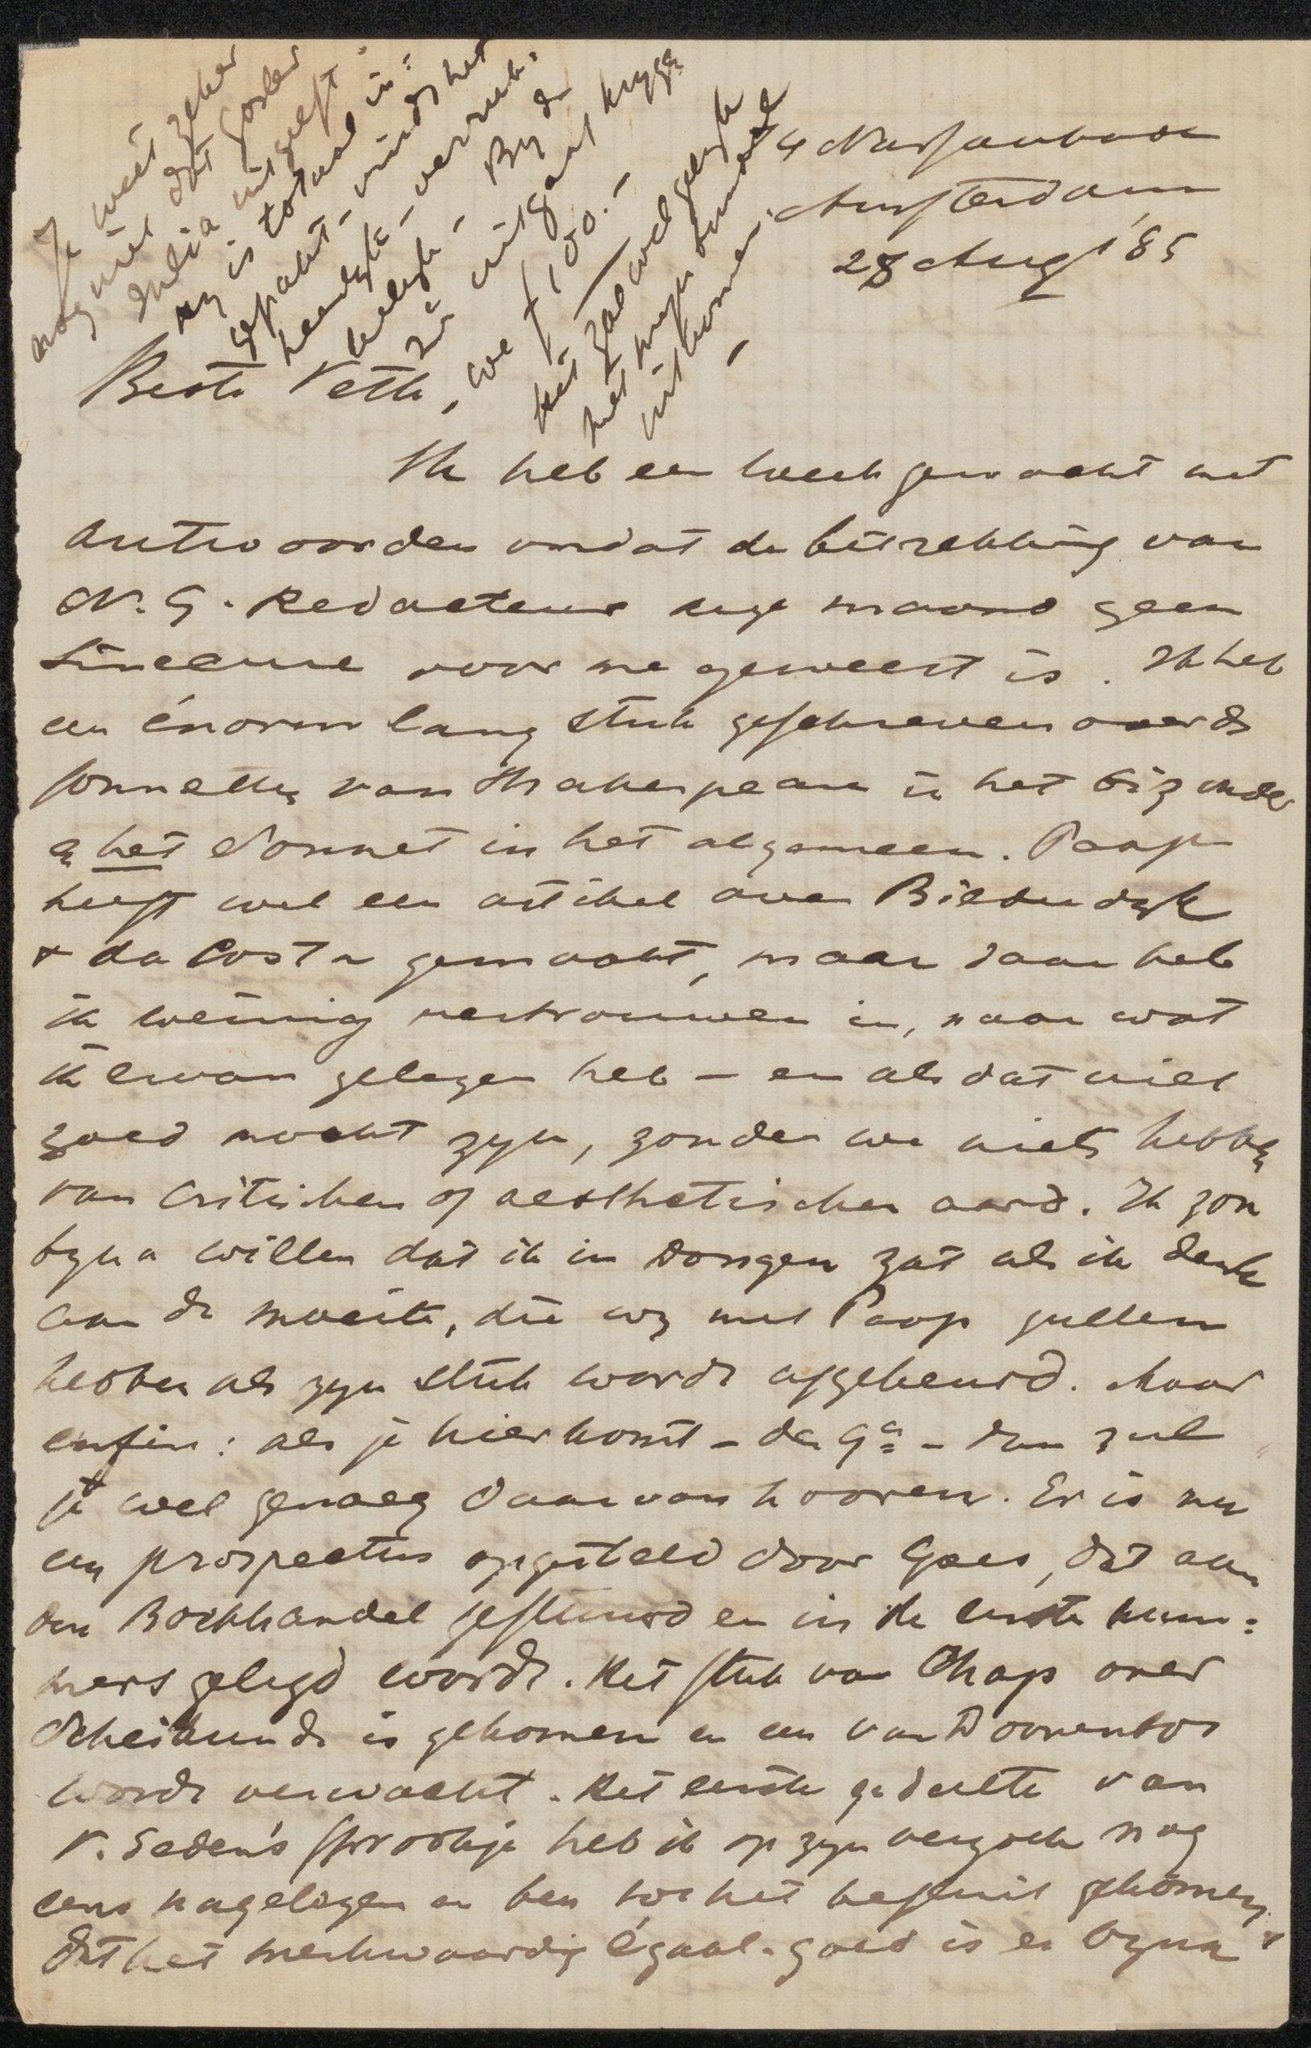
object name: letter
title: Brief aan Jan Veth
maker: albert verwey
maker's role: criticus, dichter, essayist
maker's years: 1865-1937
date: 1885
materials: ink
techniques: pen, writing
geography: amsterdam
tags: amsterdam, haarlem, print maker, draughtsman, willem bilderdijk, august allebé, william shakespeare, dordrecht, painter, designer, jan veth, publisher, adriaan rössing, jac van looij, chap van deventer, frank van der goes, frederik van eeden, zeist, frans netscher, the hague, literature ~ arts, historical persons (portraits and scenes from the life), money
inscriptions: collector's mark: ‘RPK’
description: Opgenomen in: Albert Verwey, Margaretha H. Schenkeveld, Rein van der Wiel: Briefwisseling 1 juli 1885 tot 15 december 1888, Amsterdam: EM. Querido's Uitgeverij B.V., 1993, p. 41-44.